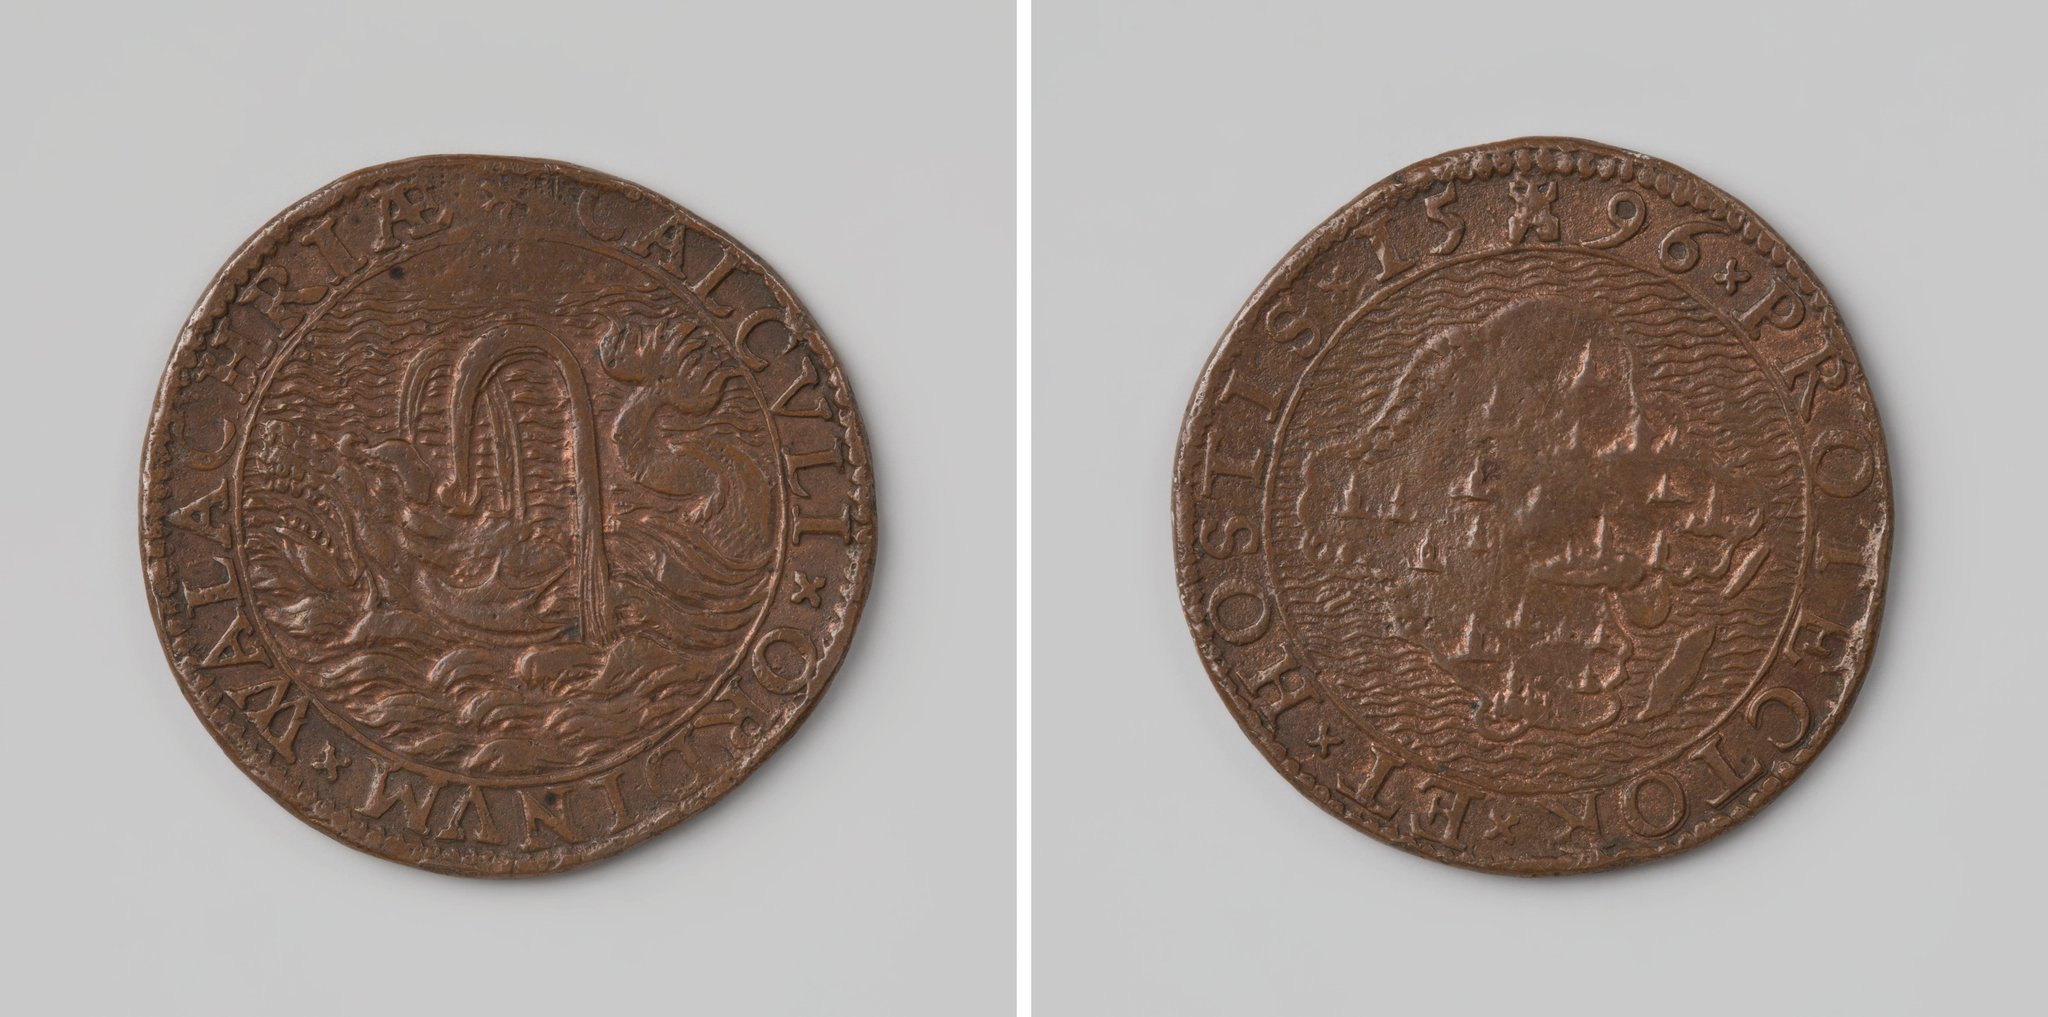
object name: jeton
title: Staten van Walcheren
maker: Anonymous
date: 1596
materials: copper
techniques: striking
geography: middelburg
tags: staten van walcheren, walcheren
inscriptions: inscription: ‘Bt CALCVLI. ORDINVM/ WALACHRIAE’, inscription: ‘16Mt46. PROTECTOR. ET. HOSTIS’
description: Koperen penning. Voorzijde: walvis met staart in lucht binnen omschrift. Keerzijde: kaart van eiland Walcheren binnen omschrift.